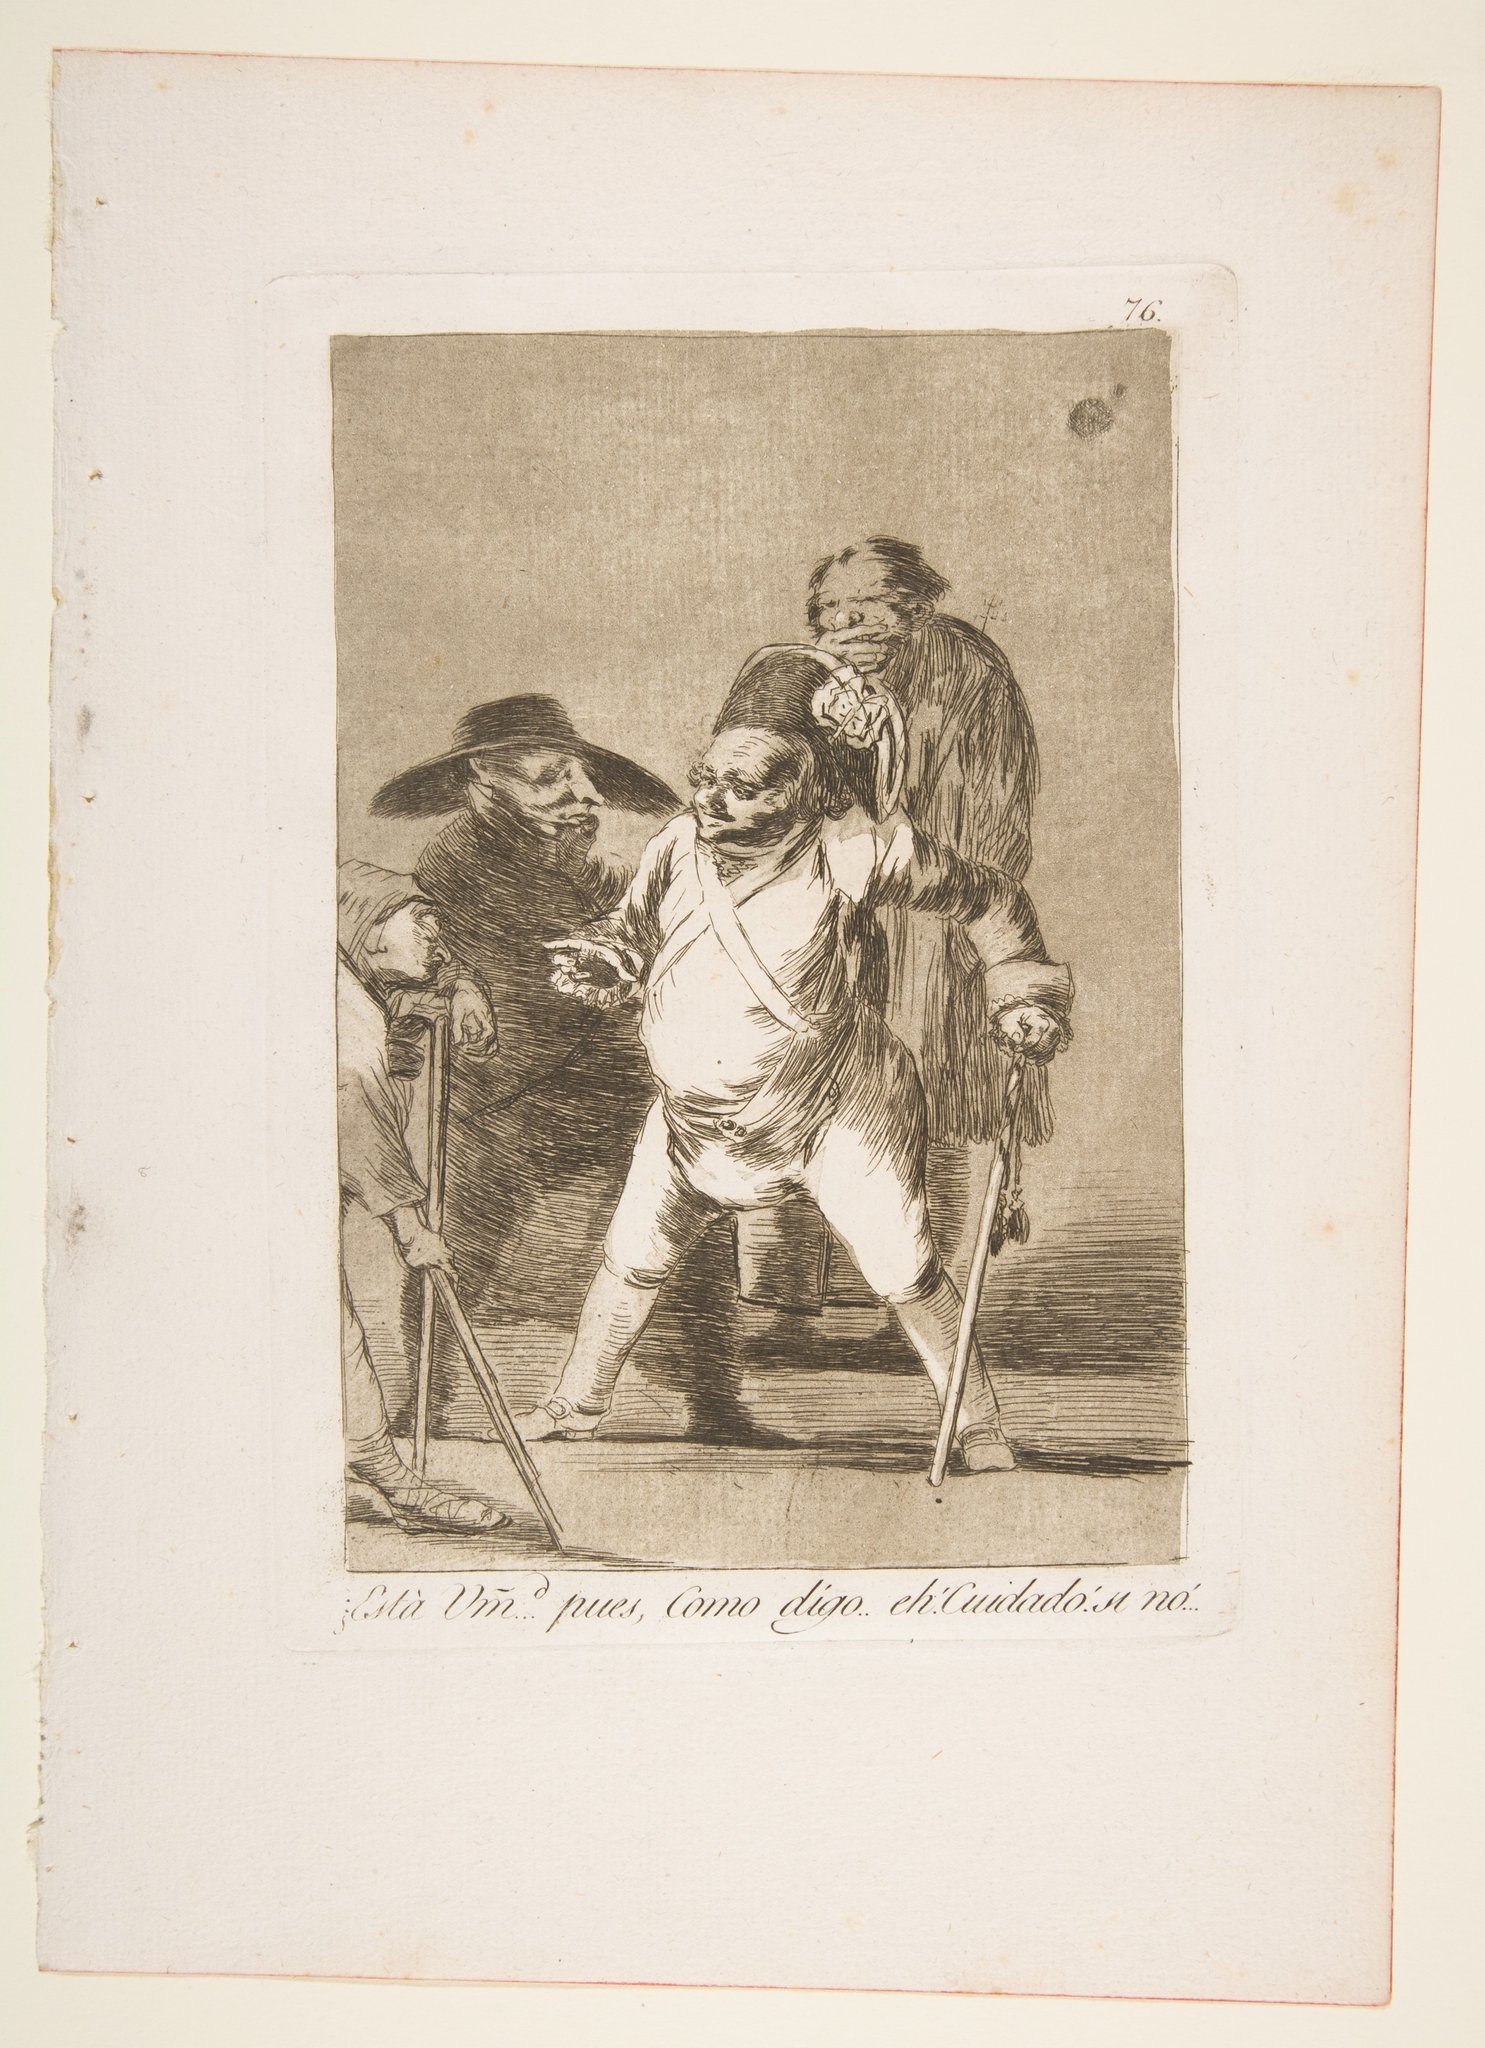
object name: print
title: Plate 76 from "Los Caprichos": You understand?... well, as I say... eh! Look out! otherwise... (¿Està Umd...pues, Como digo..eh! Cuidado! si no...)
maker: goya (francisco de goya y lucientes)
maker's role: artist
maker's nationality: spanish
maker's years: 1746-1828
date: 1799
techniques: aquatint, burnishing, etching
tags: men